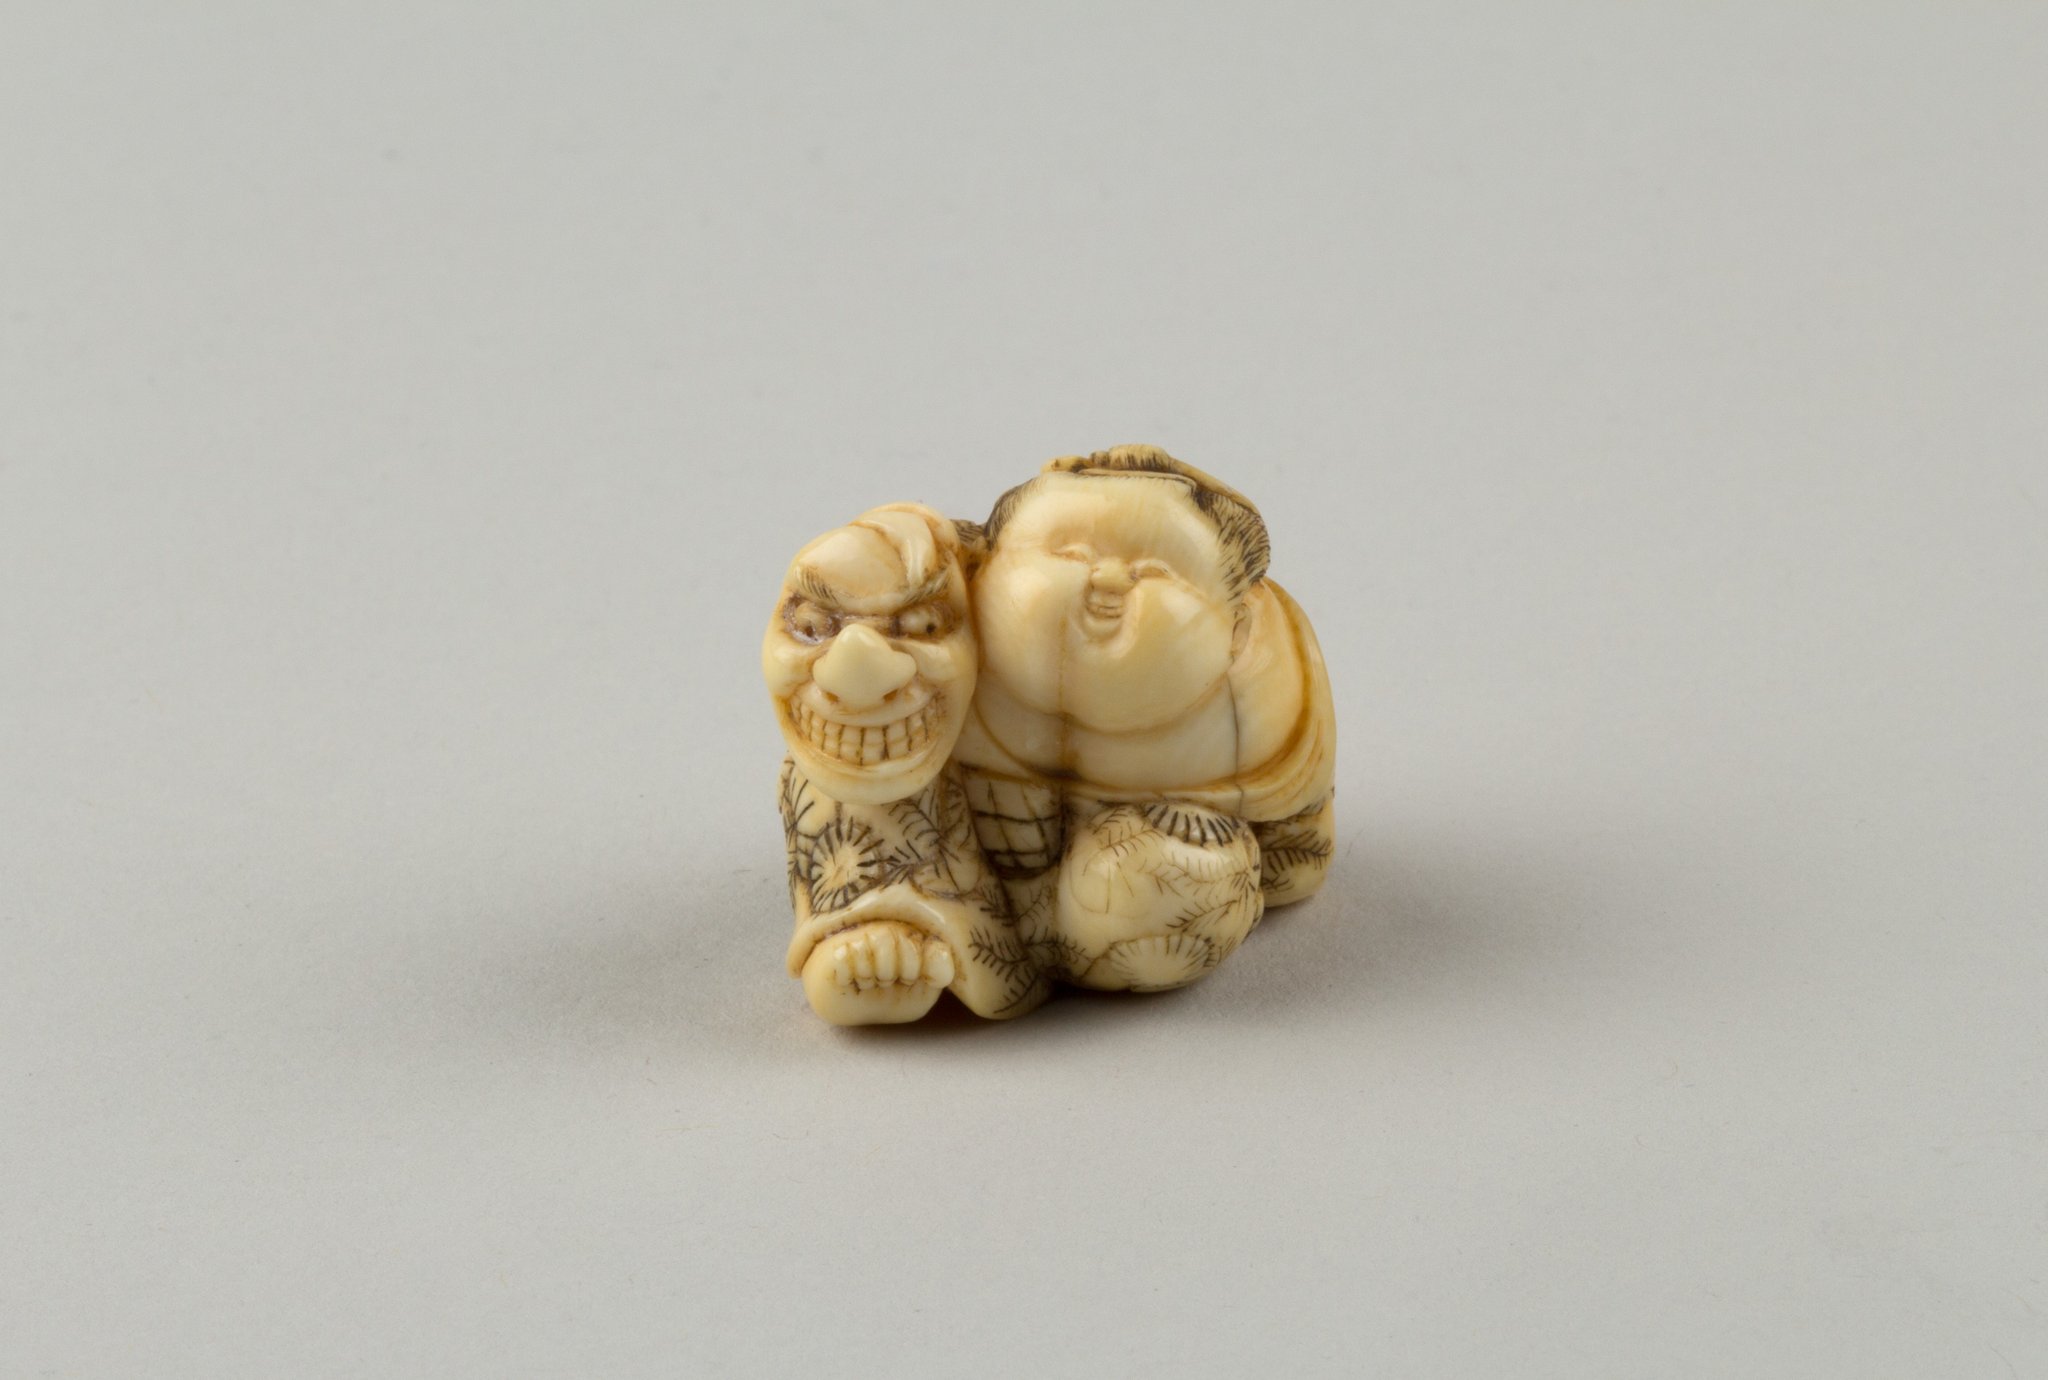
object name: netsuke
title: Netsuke of Okame Holding a Mask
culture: japanese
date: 1801-1900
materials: ivory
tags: masks